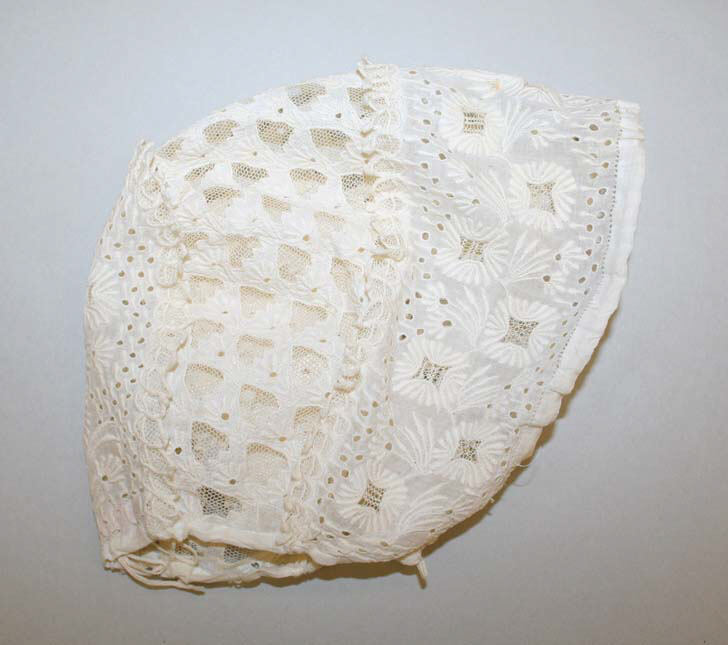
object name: cap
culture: french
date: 1829-1840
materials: cotton